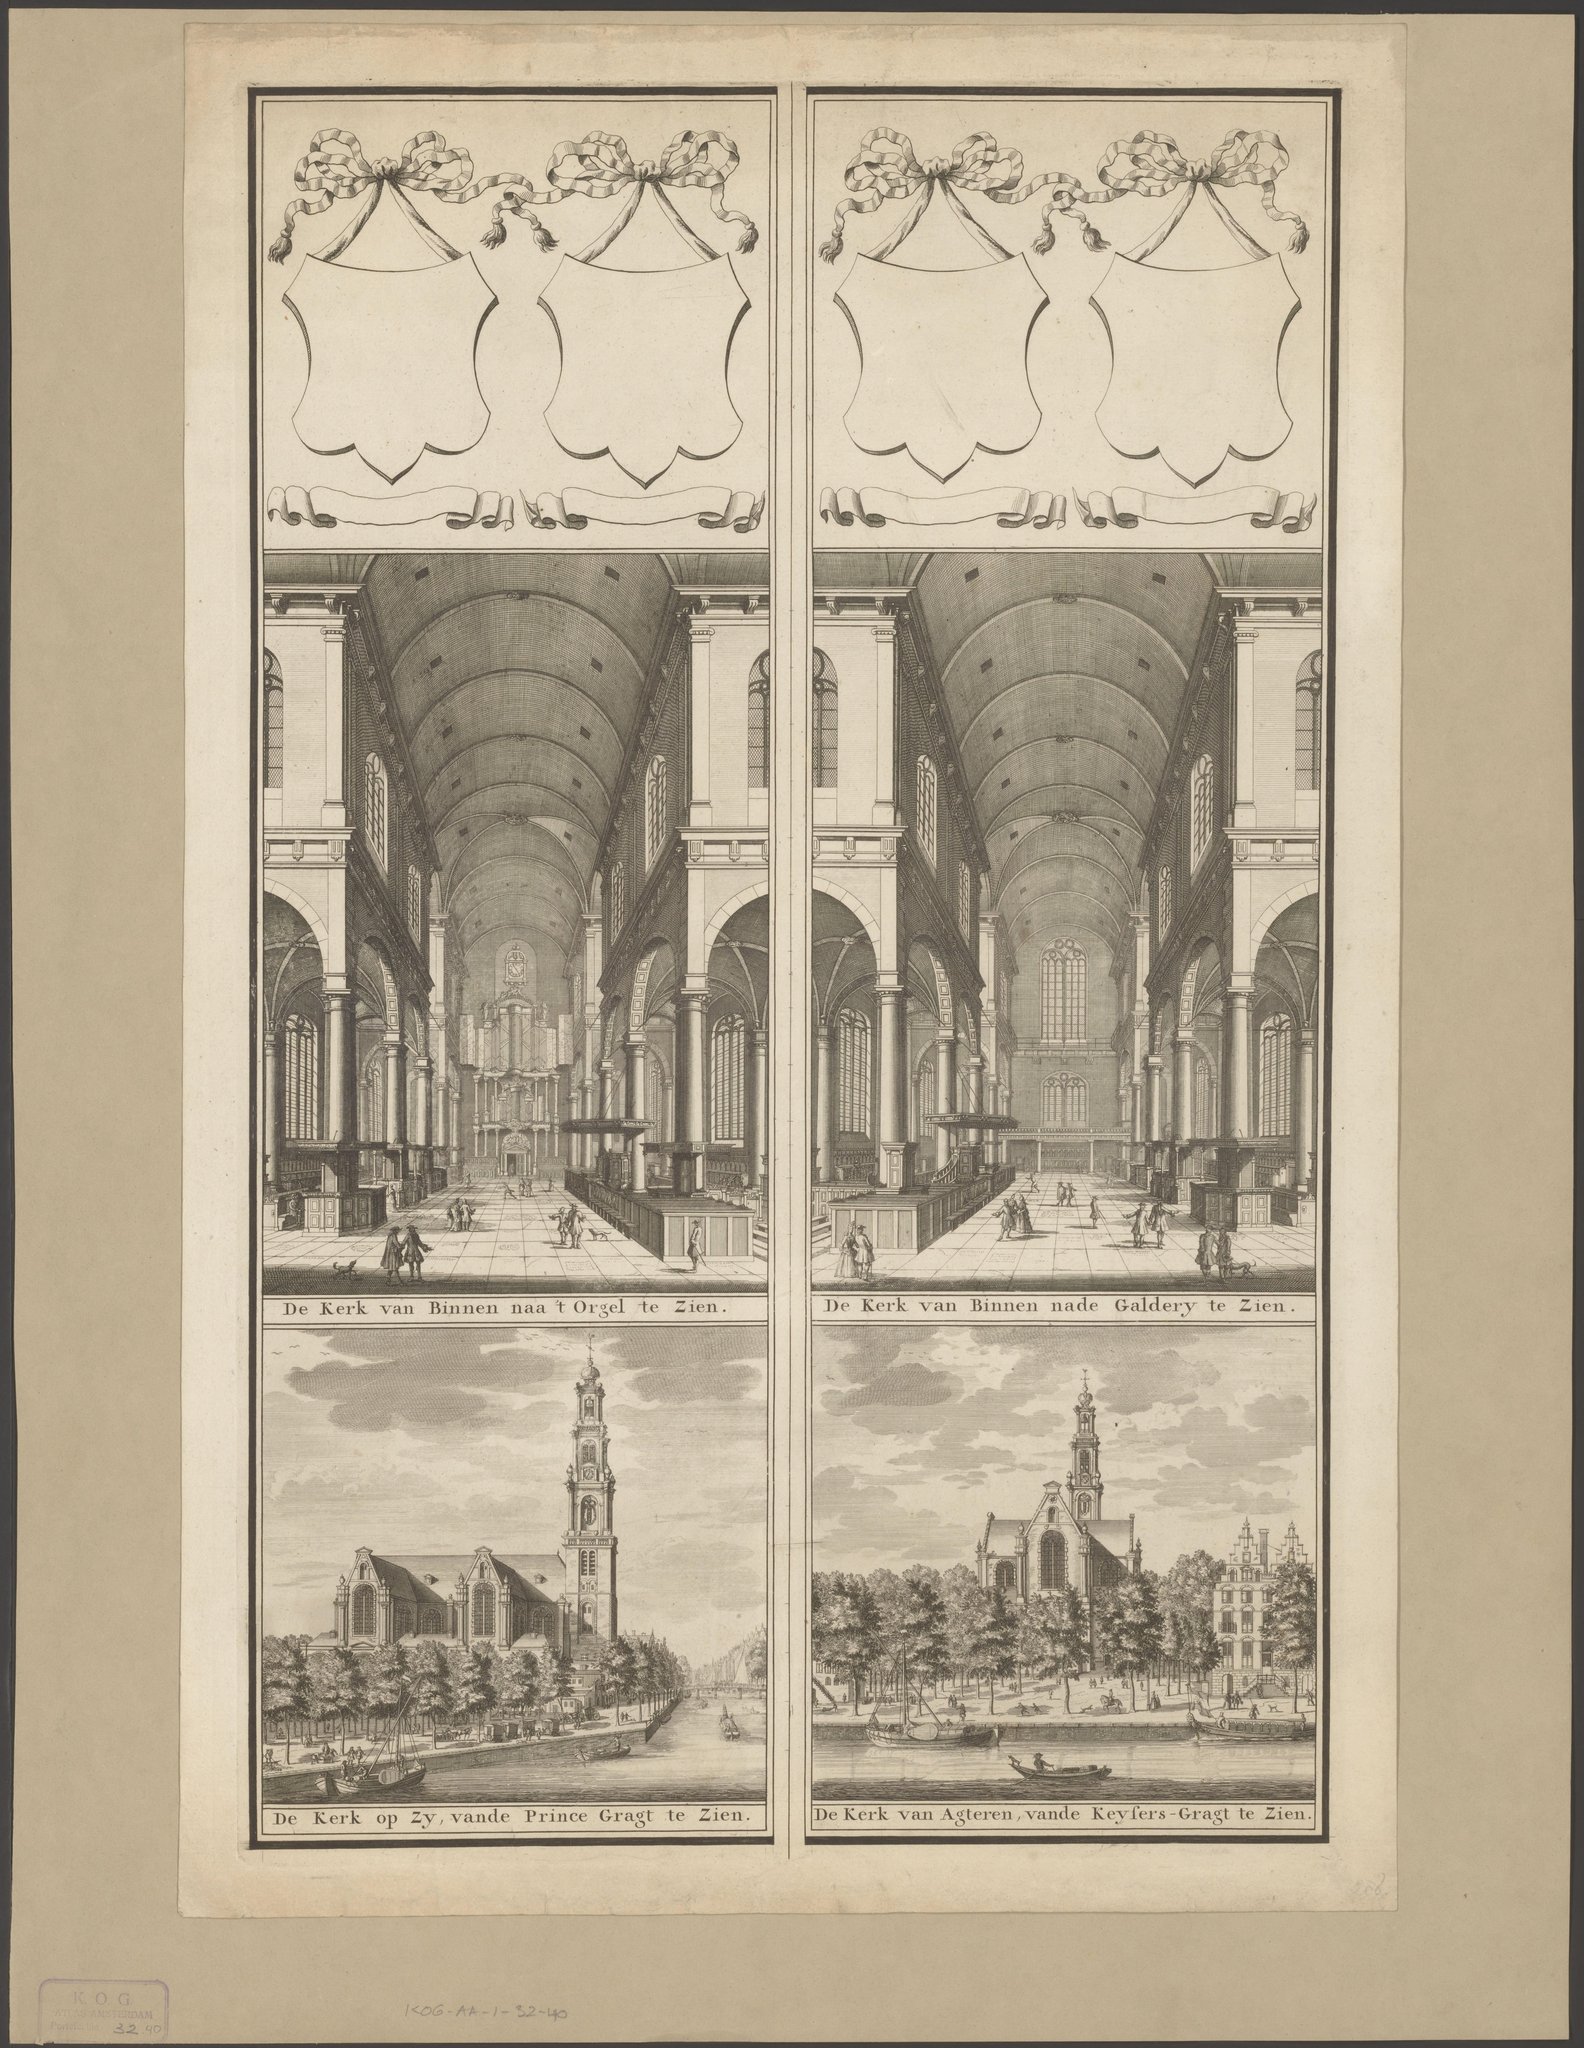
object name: print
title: De Kerk van Binnen naa 't Orgel te Zien / De Kerk op Zy, vande Prince Gragt te Zien / De Kerk van Binnen nade Galdery te Zien / De Kerk van Agteren, vande Keysers-Gragt te Zien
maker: daniël stopendaal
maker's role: print maker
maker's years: 1672-1726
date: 1685-1726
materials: paper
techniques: engraving, etching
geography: amsterdam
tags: coat of arms (as symbol of the state, etc.) (+ city; municipal), church (exterior), interior of church, plan ~ architecture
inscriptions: collector's mark: ‘ 32.40 ’ Lugt 1641b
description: Zijn waarschijnlijk oorspronkelijk de randprenten van 'Caart vande Sitplaat-sen inde Wester-Kerk', een plattegrond van de zitplaatsen in de Westerkerk. Daniël Stopendaal staat als prentmaker vermeld op de plattegrond zelf, de randprenten zijn mogelijk ook door hem gemaakt. Zie RP-P-AO-23-46-1, RP-P-AO-23-46-2 en RP-P-AO-23-47A voor andere bijhorende randprenten. Zie RP-P-AO-23-57 voor een soortgelijke plattegrond van de Oosterkerk met randprenten.